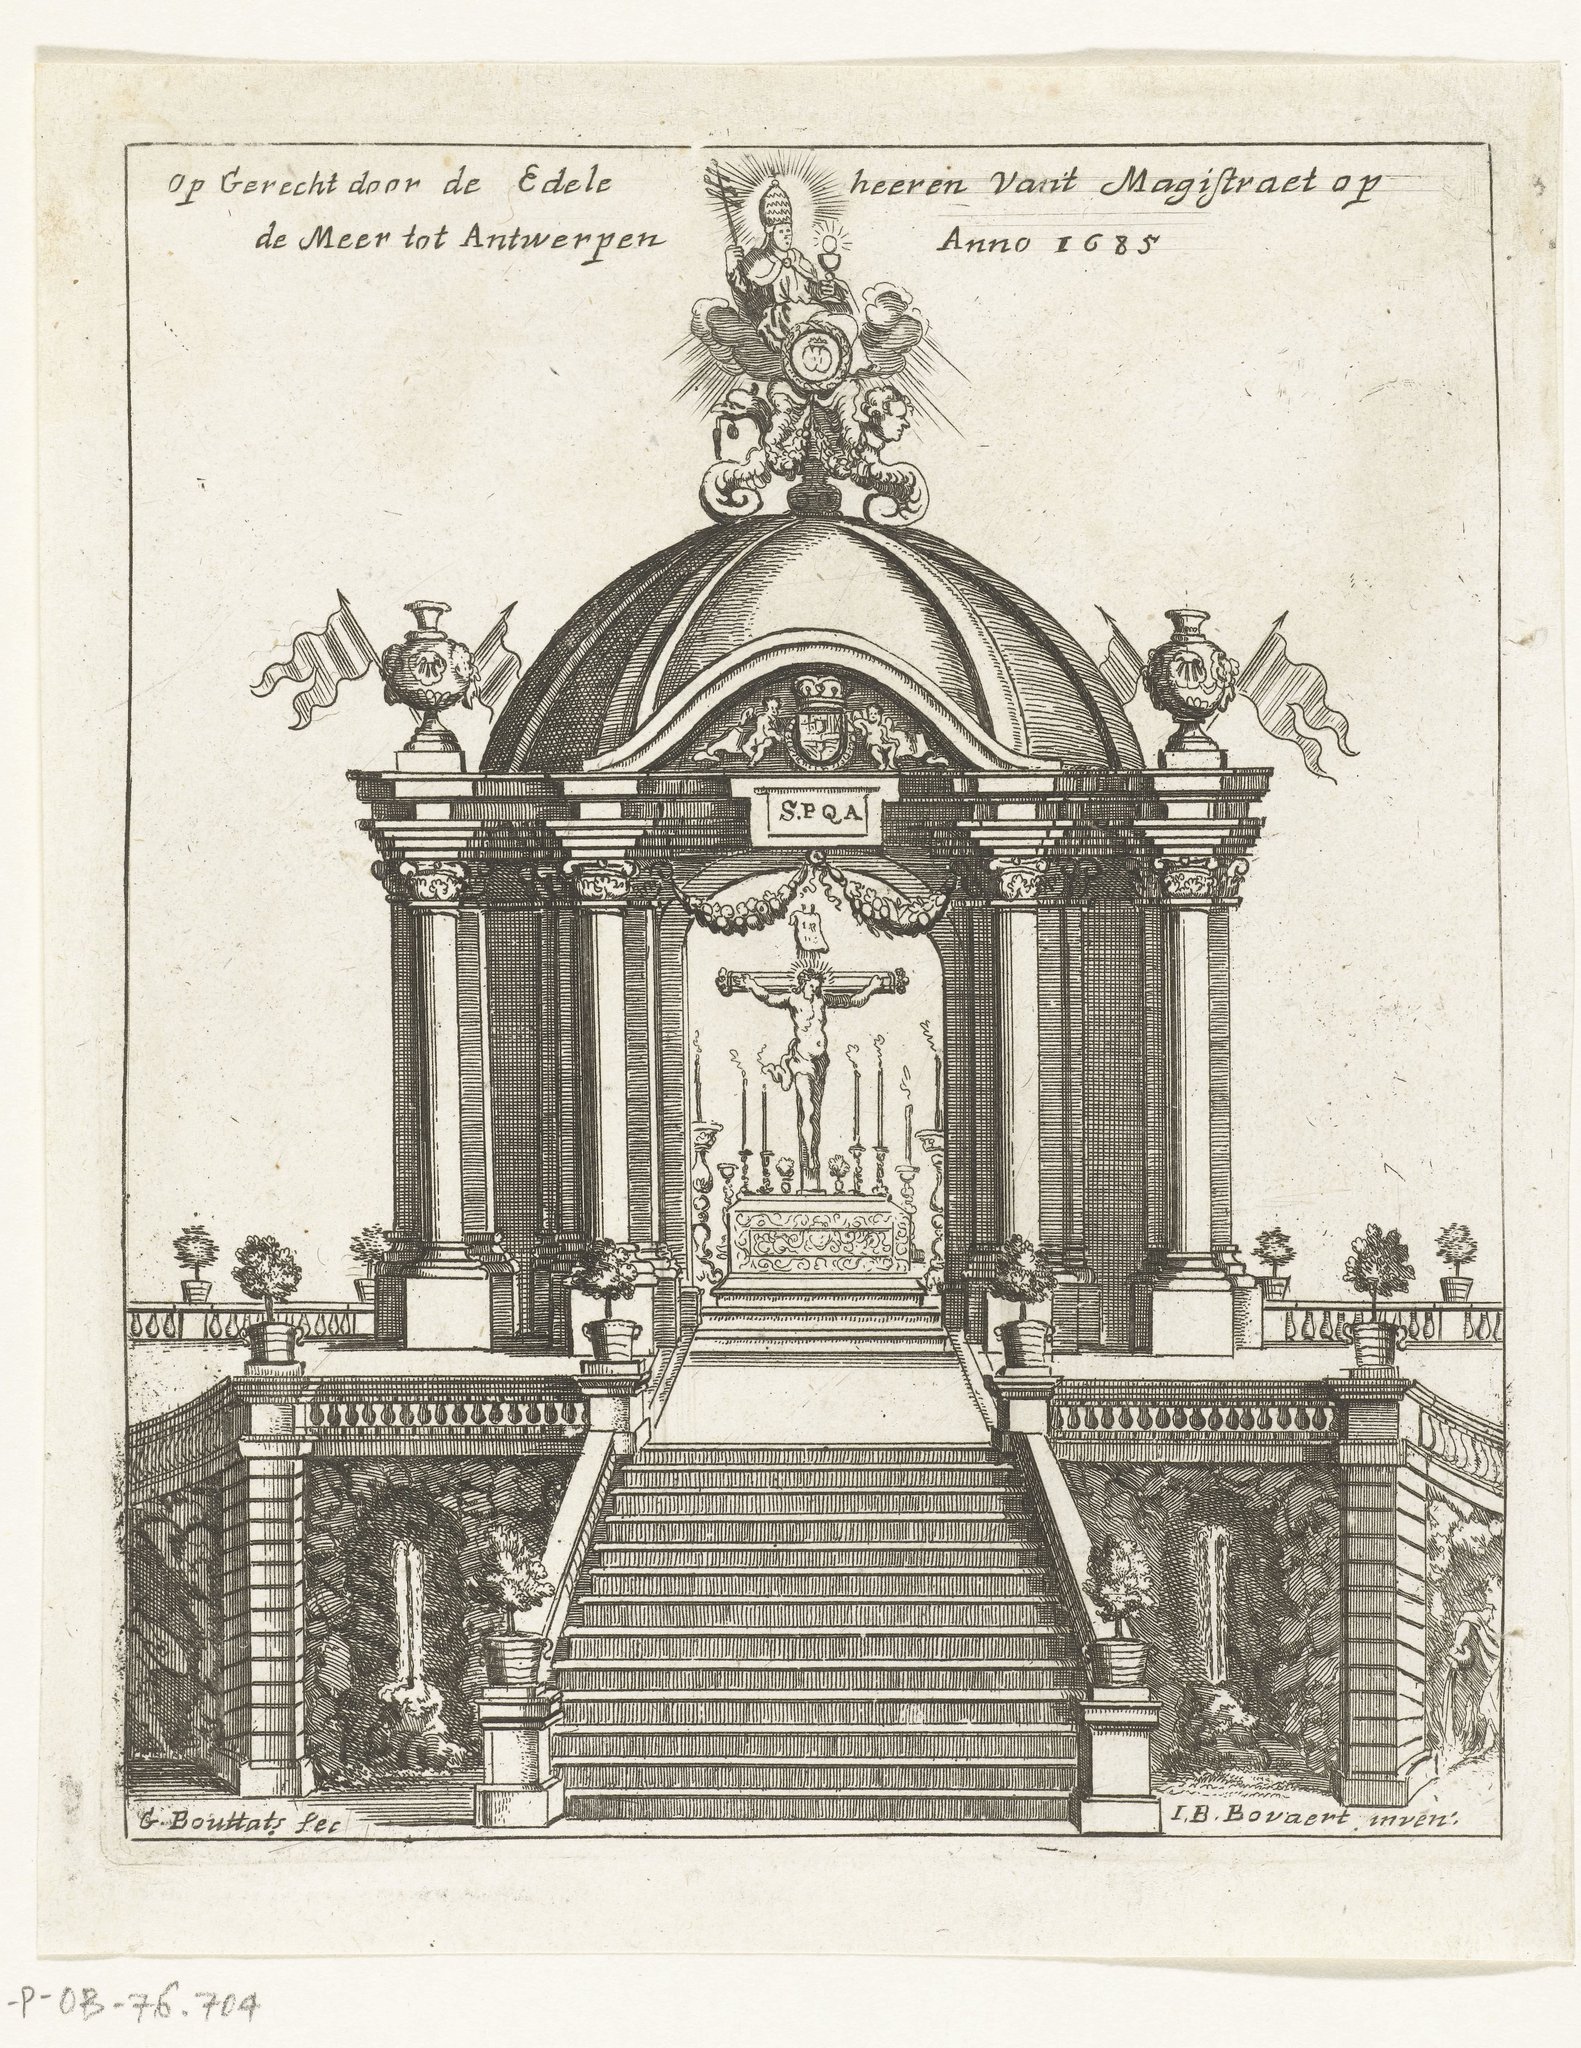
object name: print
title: Op Gerecht door de Edele heeren van't Magistraet op de Meer tot Antwerpen Anno 1685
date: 1685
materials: paper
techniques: etching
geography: southern netherlands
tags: other decorative structures (~ triumphal entry, etc.), antwerp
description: Gebruikt als illustratie in: Hondert-jaerigh jubile-vreught bewesen in dese stadt Antwerpen ter oorsaecke vande herstellinge des geloofs in't jaer 1585. door de glorieuse waepenen van sijne catholijcke majesteyt, onder t'beleyt van ... Alexander Farnesius ... / Ghemaeckt ende by-een vergadert door ... Petrus Franciscus de Smidt, Hieronymus Verdussen den jonghere, Antwerpen 1685.